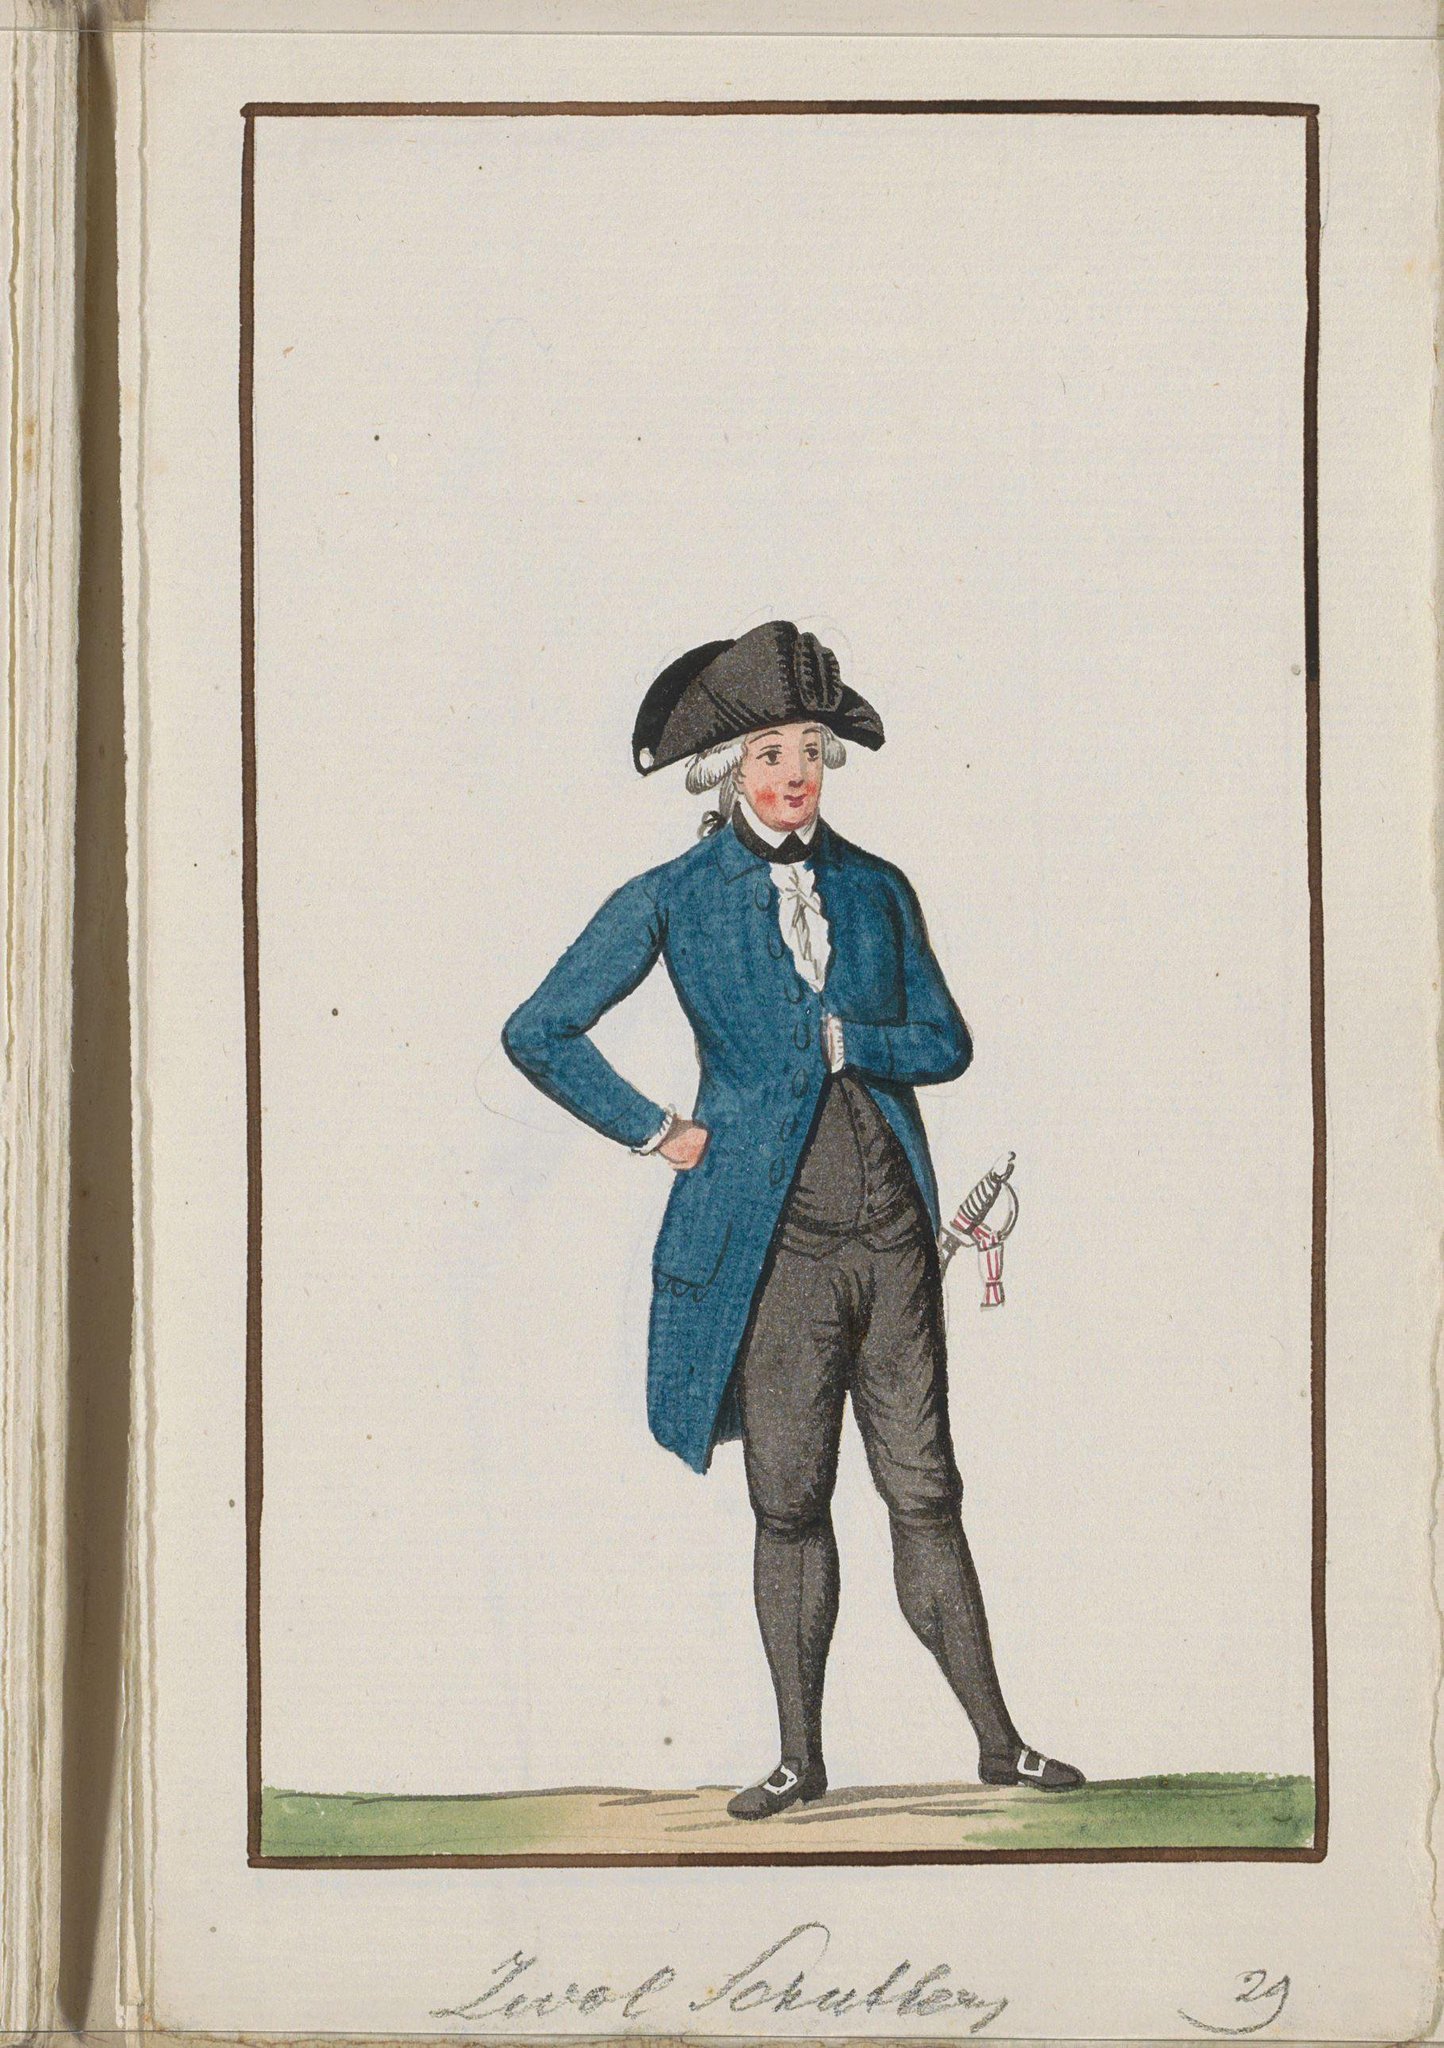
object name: drawing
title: Swol Schuttery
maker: Anonymous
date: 1789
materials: paper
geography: northern netherlands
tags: (military) uniforms (+ citizen soldiery, civil guard, citizen militia), patriots (1780-1795)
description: Montering of uniform van de schutterij van Zwolle, ca. 1785. Onderdeel van een schetsboek met 41 gekleurde tekeningen van de monteringen van de gewapende schutterijen en burgercorpsen in Nederland in de periode ca. 1783-1789.